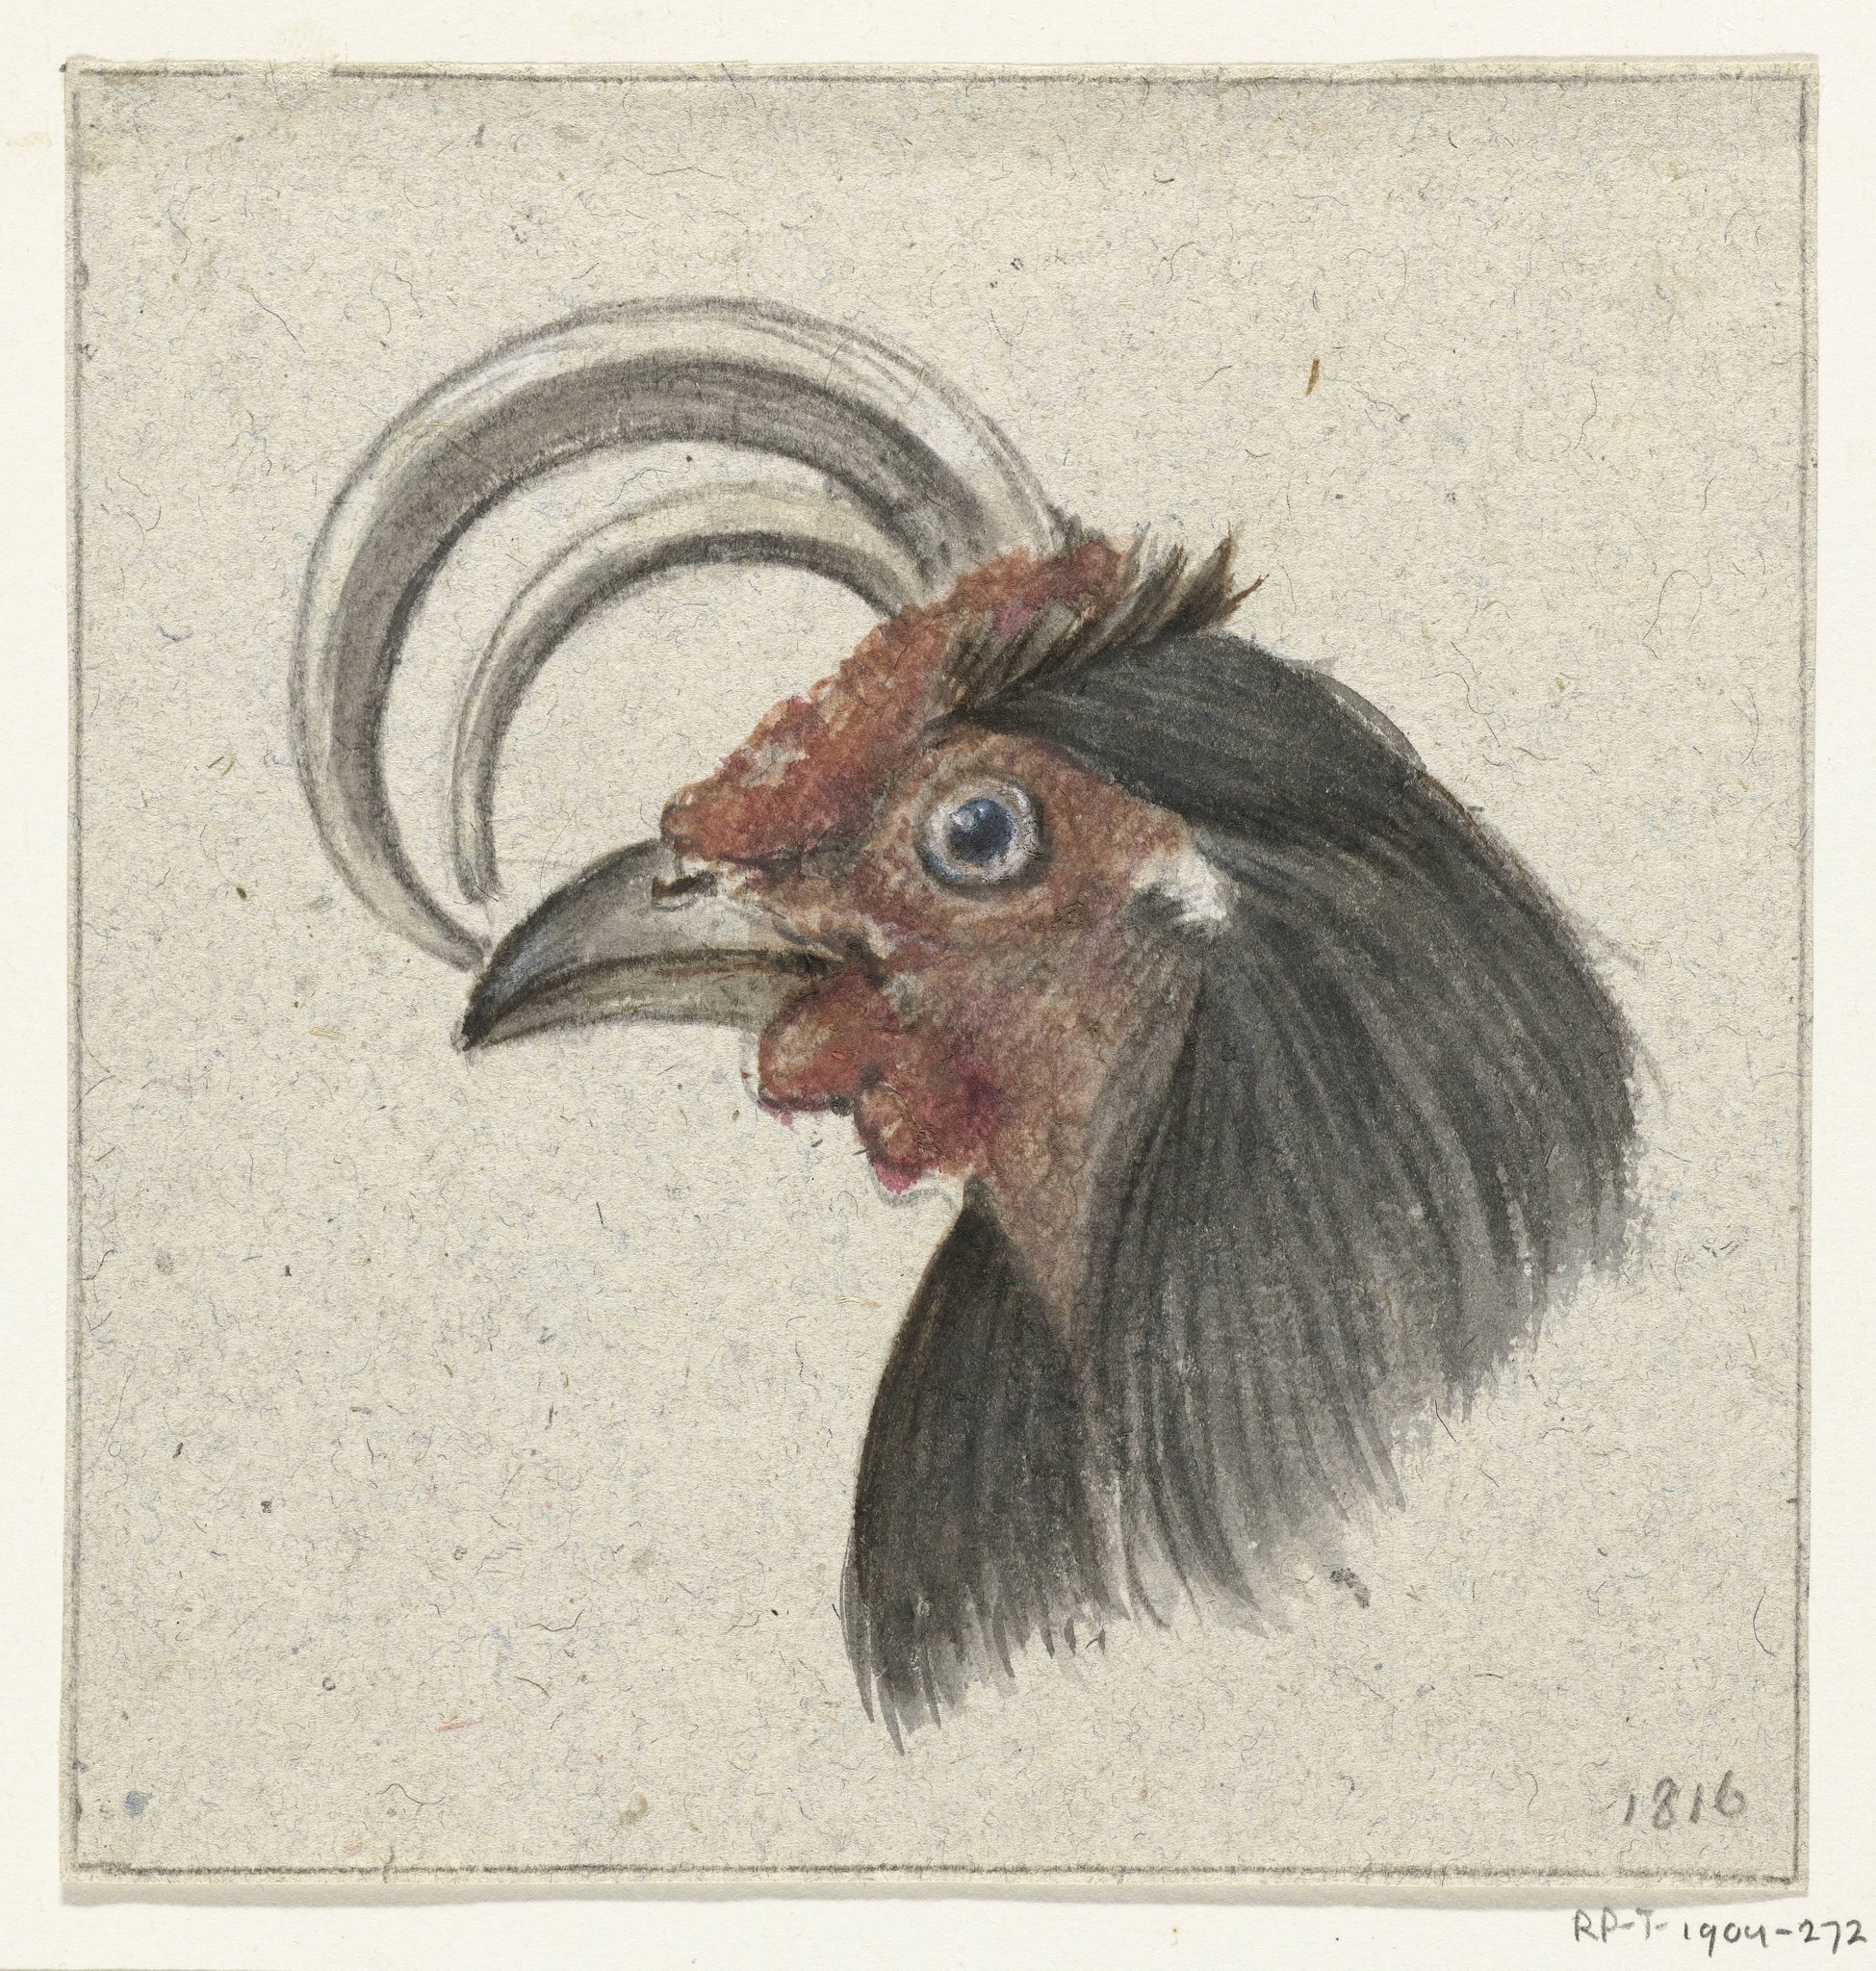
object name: drawing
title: Kop van een haan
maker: jean bernard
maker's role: draughtsman, print maker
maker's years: 1765-1833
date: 1816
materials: chalk, ink, paper, pencil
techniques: brush, pen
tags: fowl (cock, hen, chicken, etc.)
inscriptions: date: ‘1816’